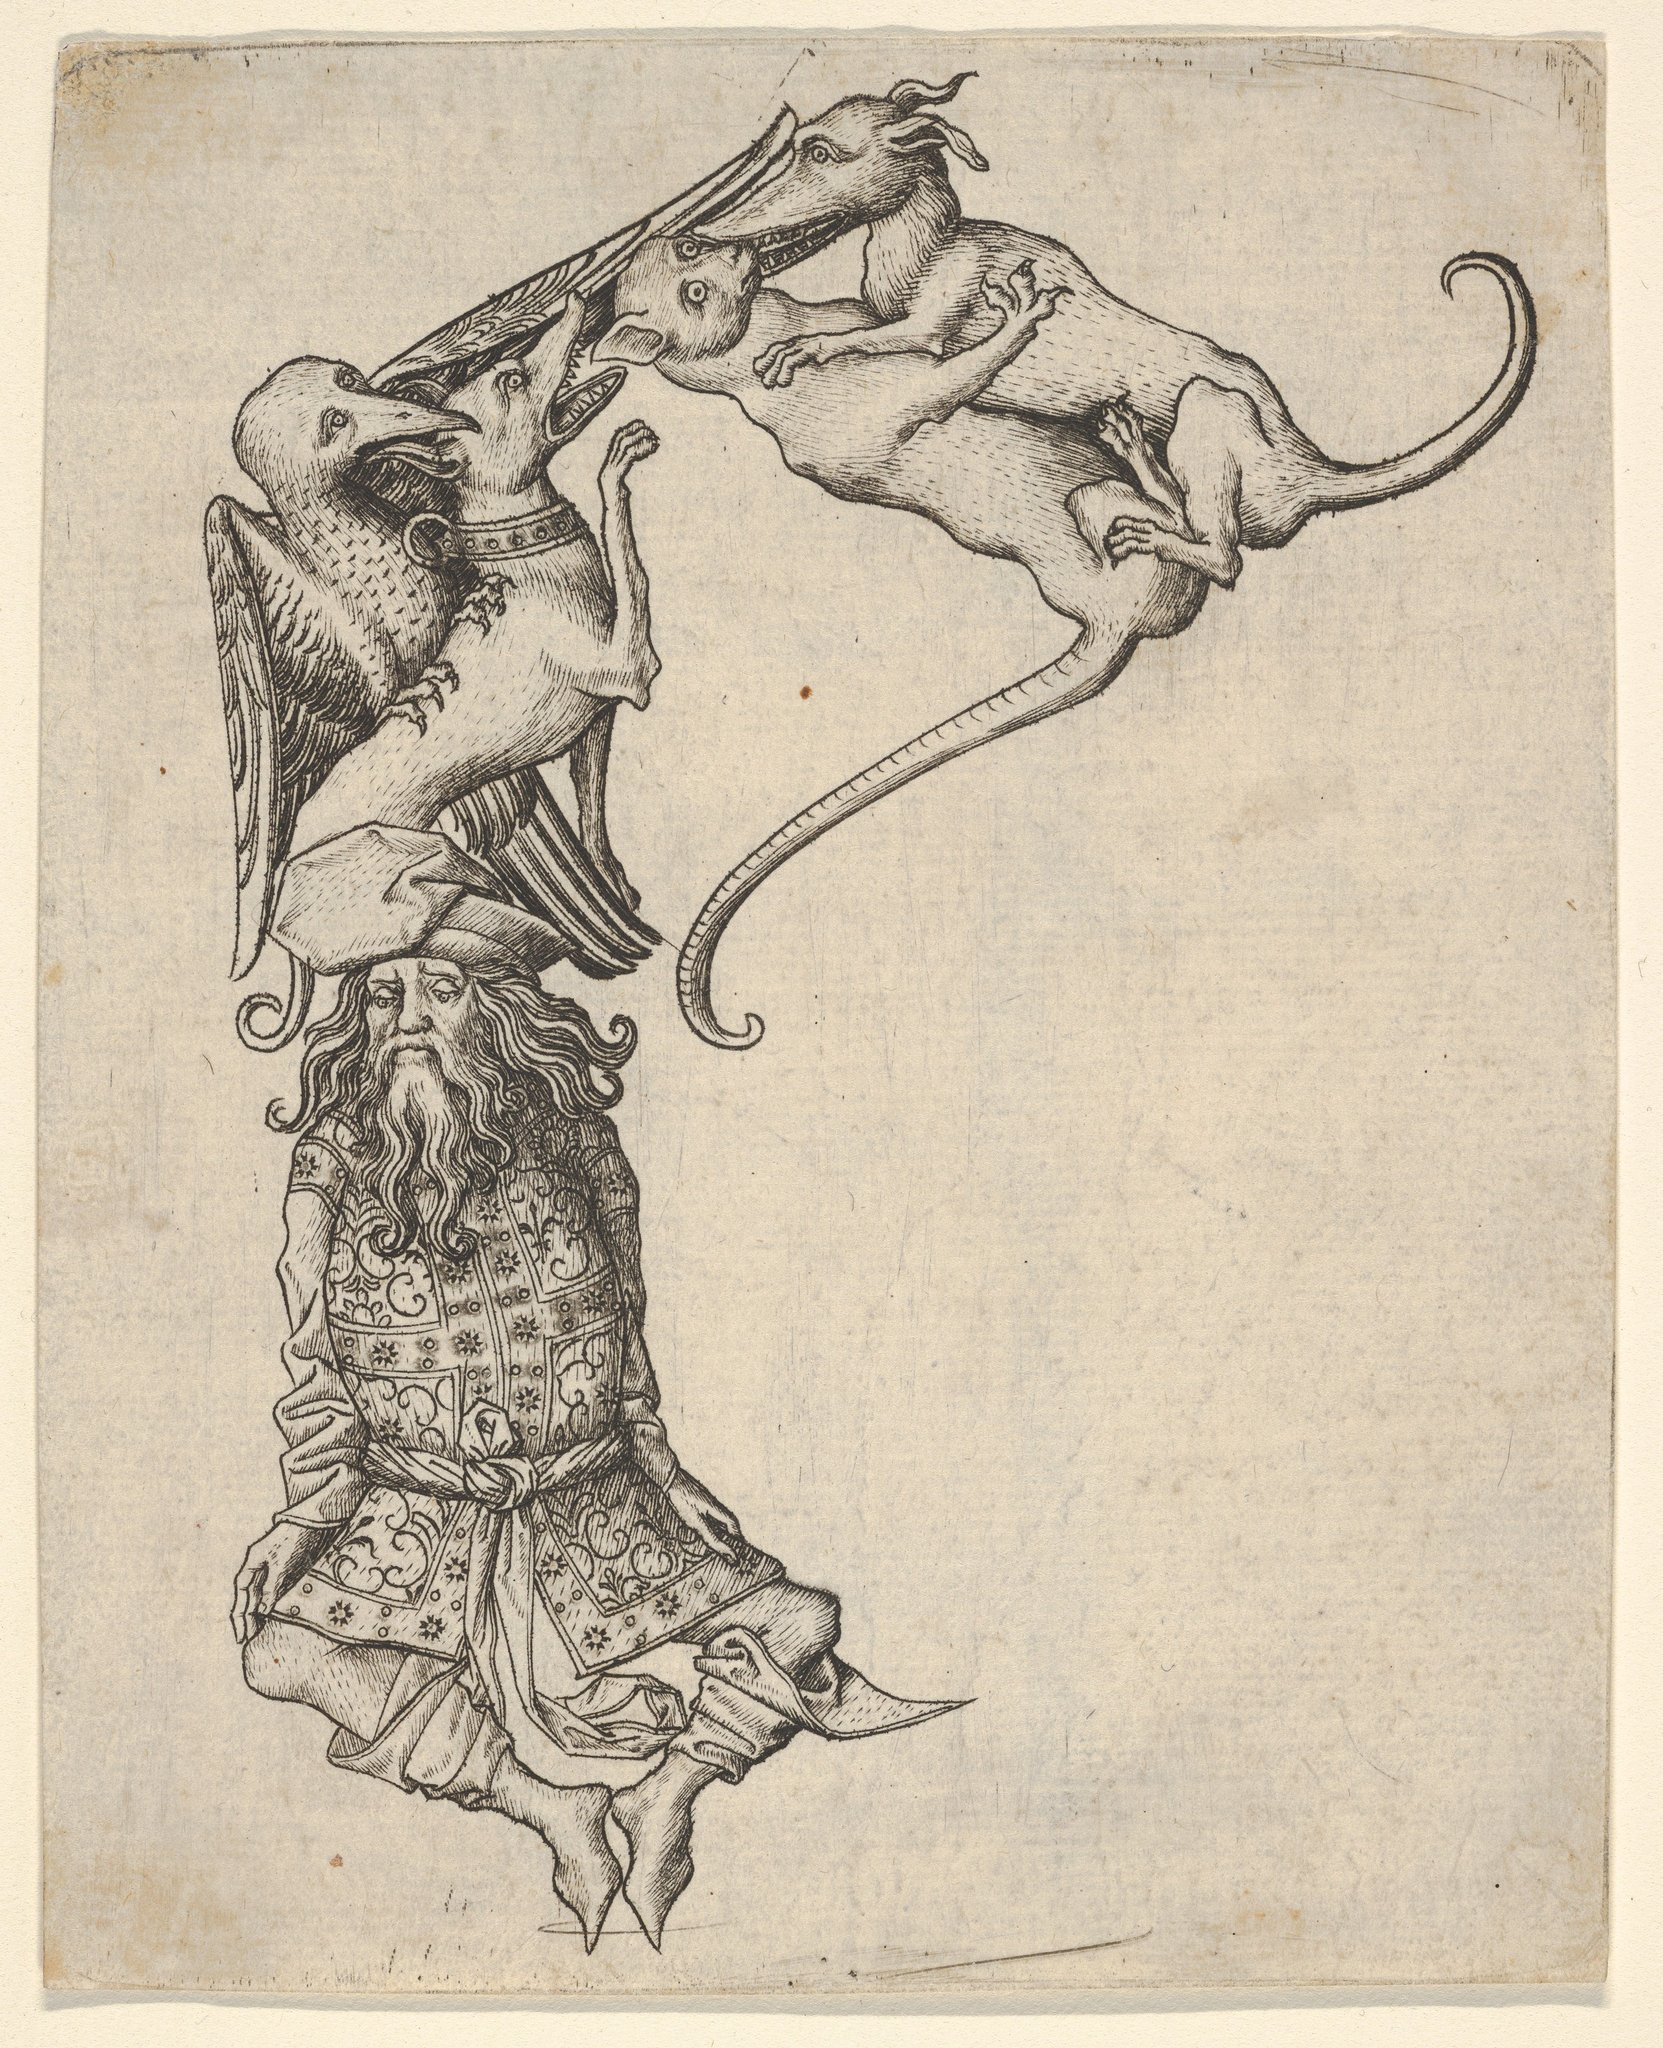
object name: print engraving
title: The Letter E, from The Alphabet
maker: master es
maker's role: artist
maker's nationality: german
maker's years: 1445-1467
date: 1466-1467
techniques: engraving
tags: birds,men,cats,dogs